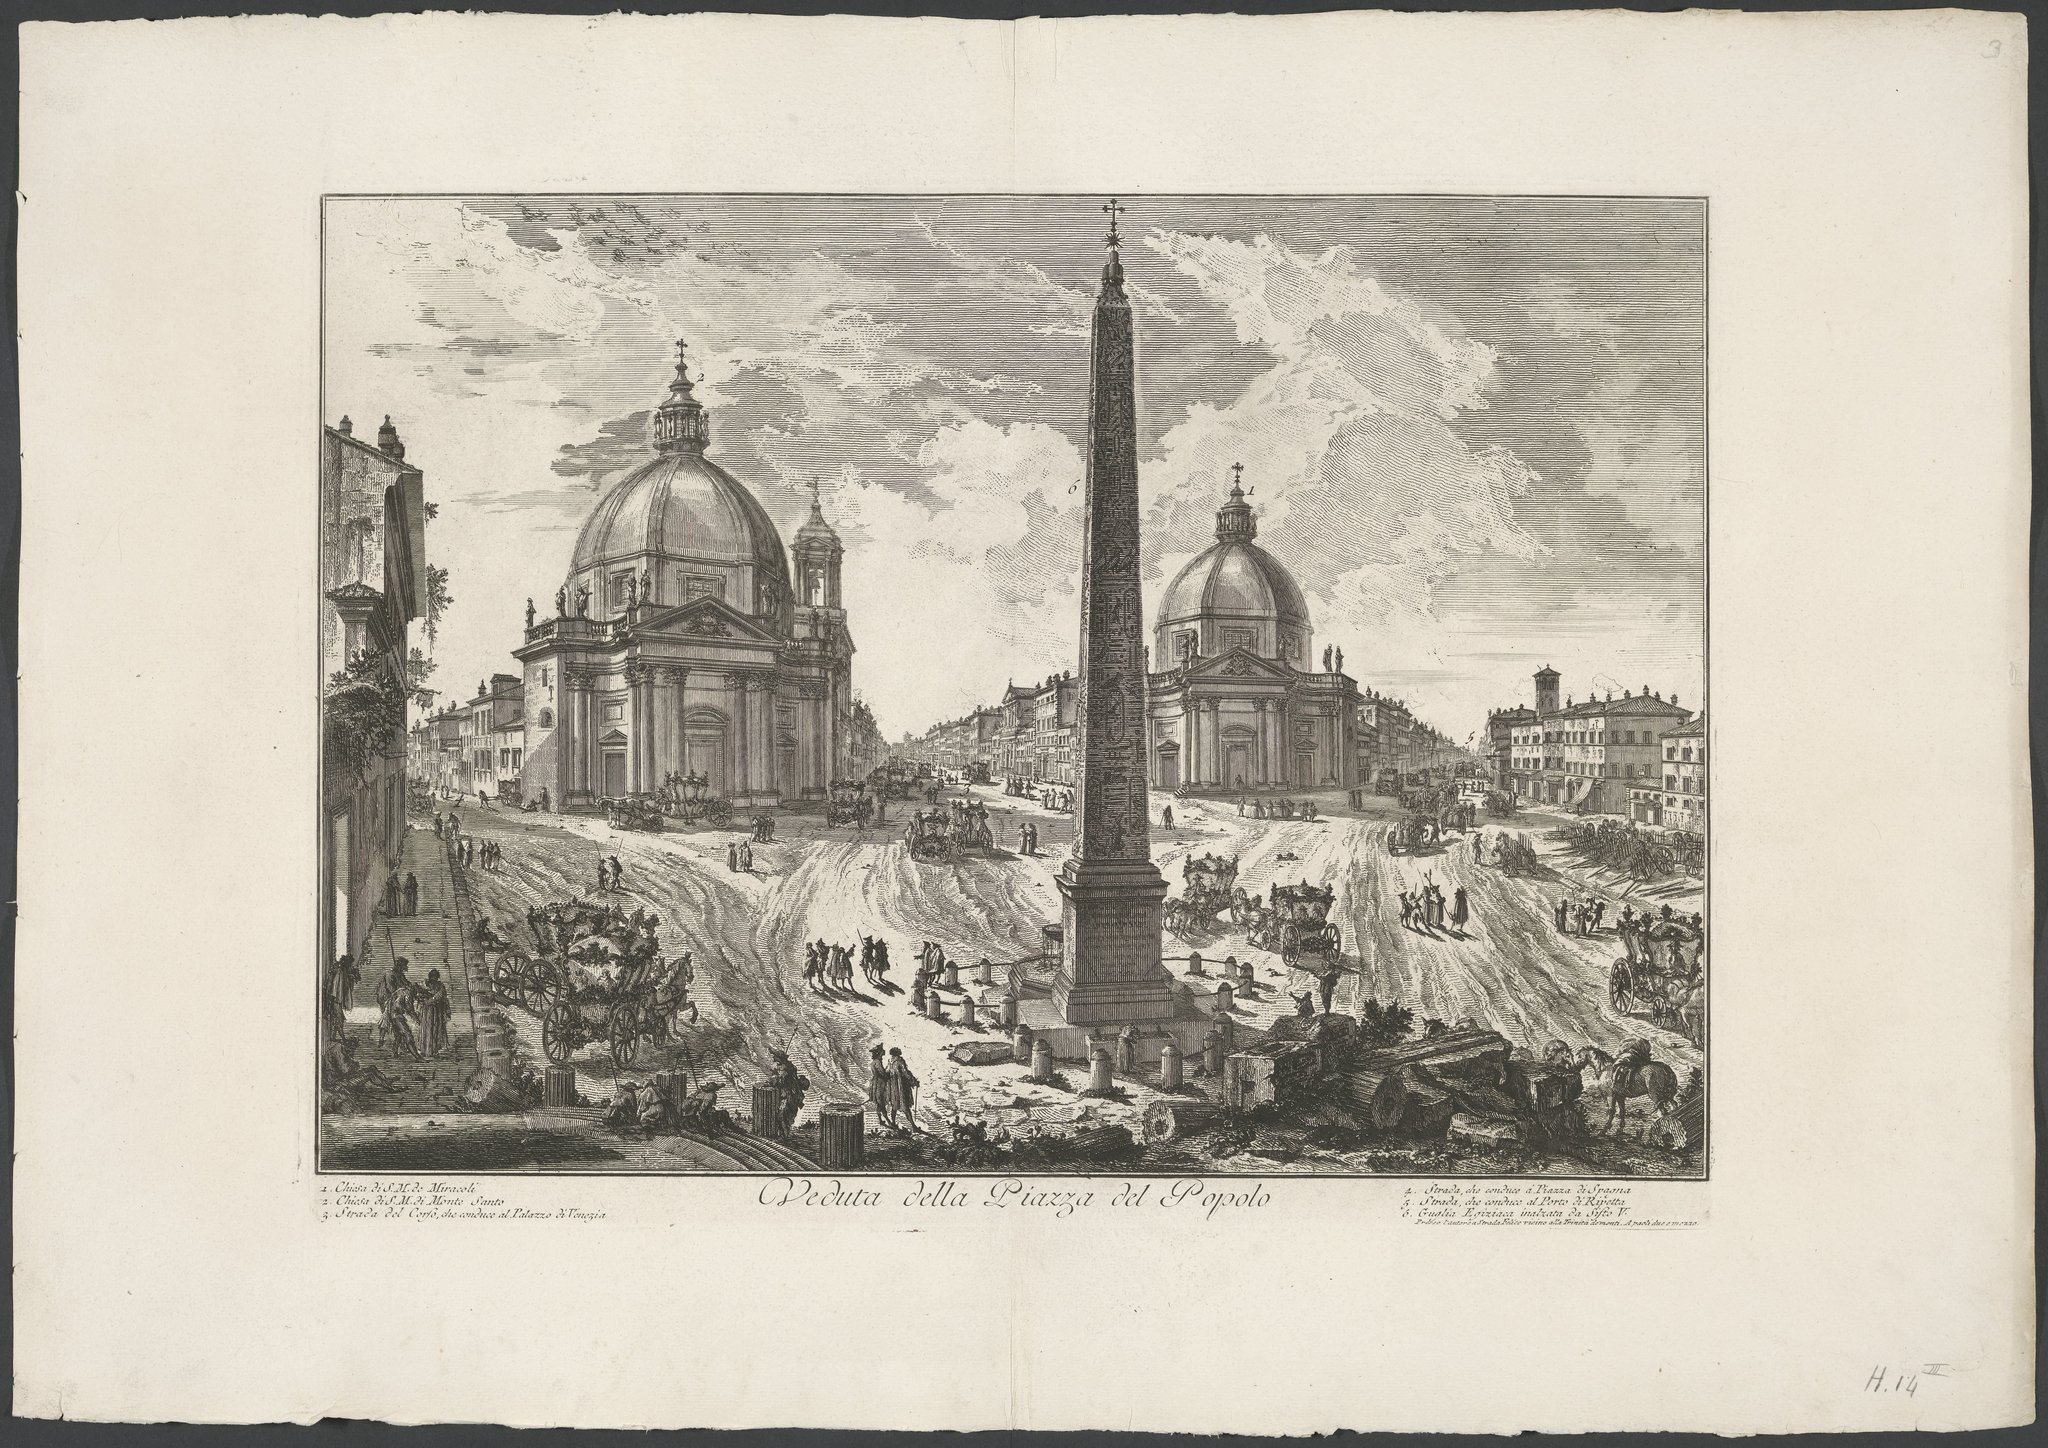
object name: print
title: Vedute di Roma disegnate ed incise da Giambattista Piranesi architetto Ve(nez)iano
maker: giovanni battista piranesi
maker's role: designer, draughtsman, print maker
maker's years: 1720-1778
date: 1748-1778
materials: paper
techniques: etching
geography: rome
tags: square, place, circus, etc., obelisk, needle, church (exterior), roman catholic church, rome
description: Deze prent maakt deel uit van de serie 'Vedute di Roma'. Piranesi werkte aan deze 135 platen tellende serie tussen 1748 en zijn dood in 1778. Francesco Piranesi voegde later nog twee prenten toe aan de reeks van zijn vader.